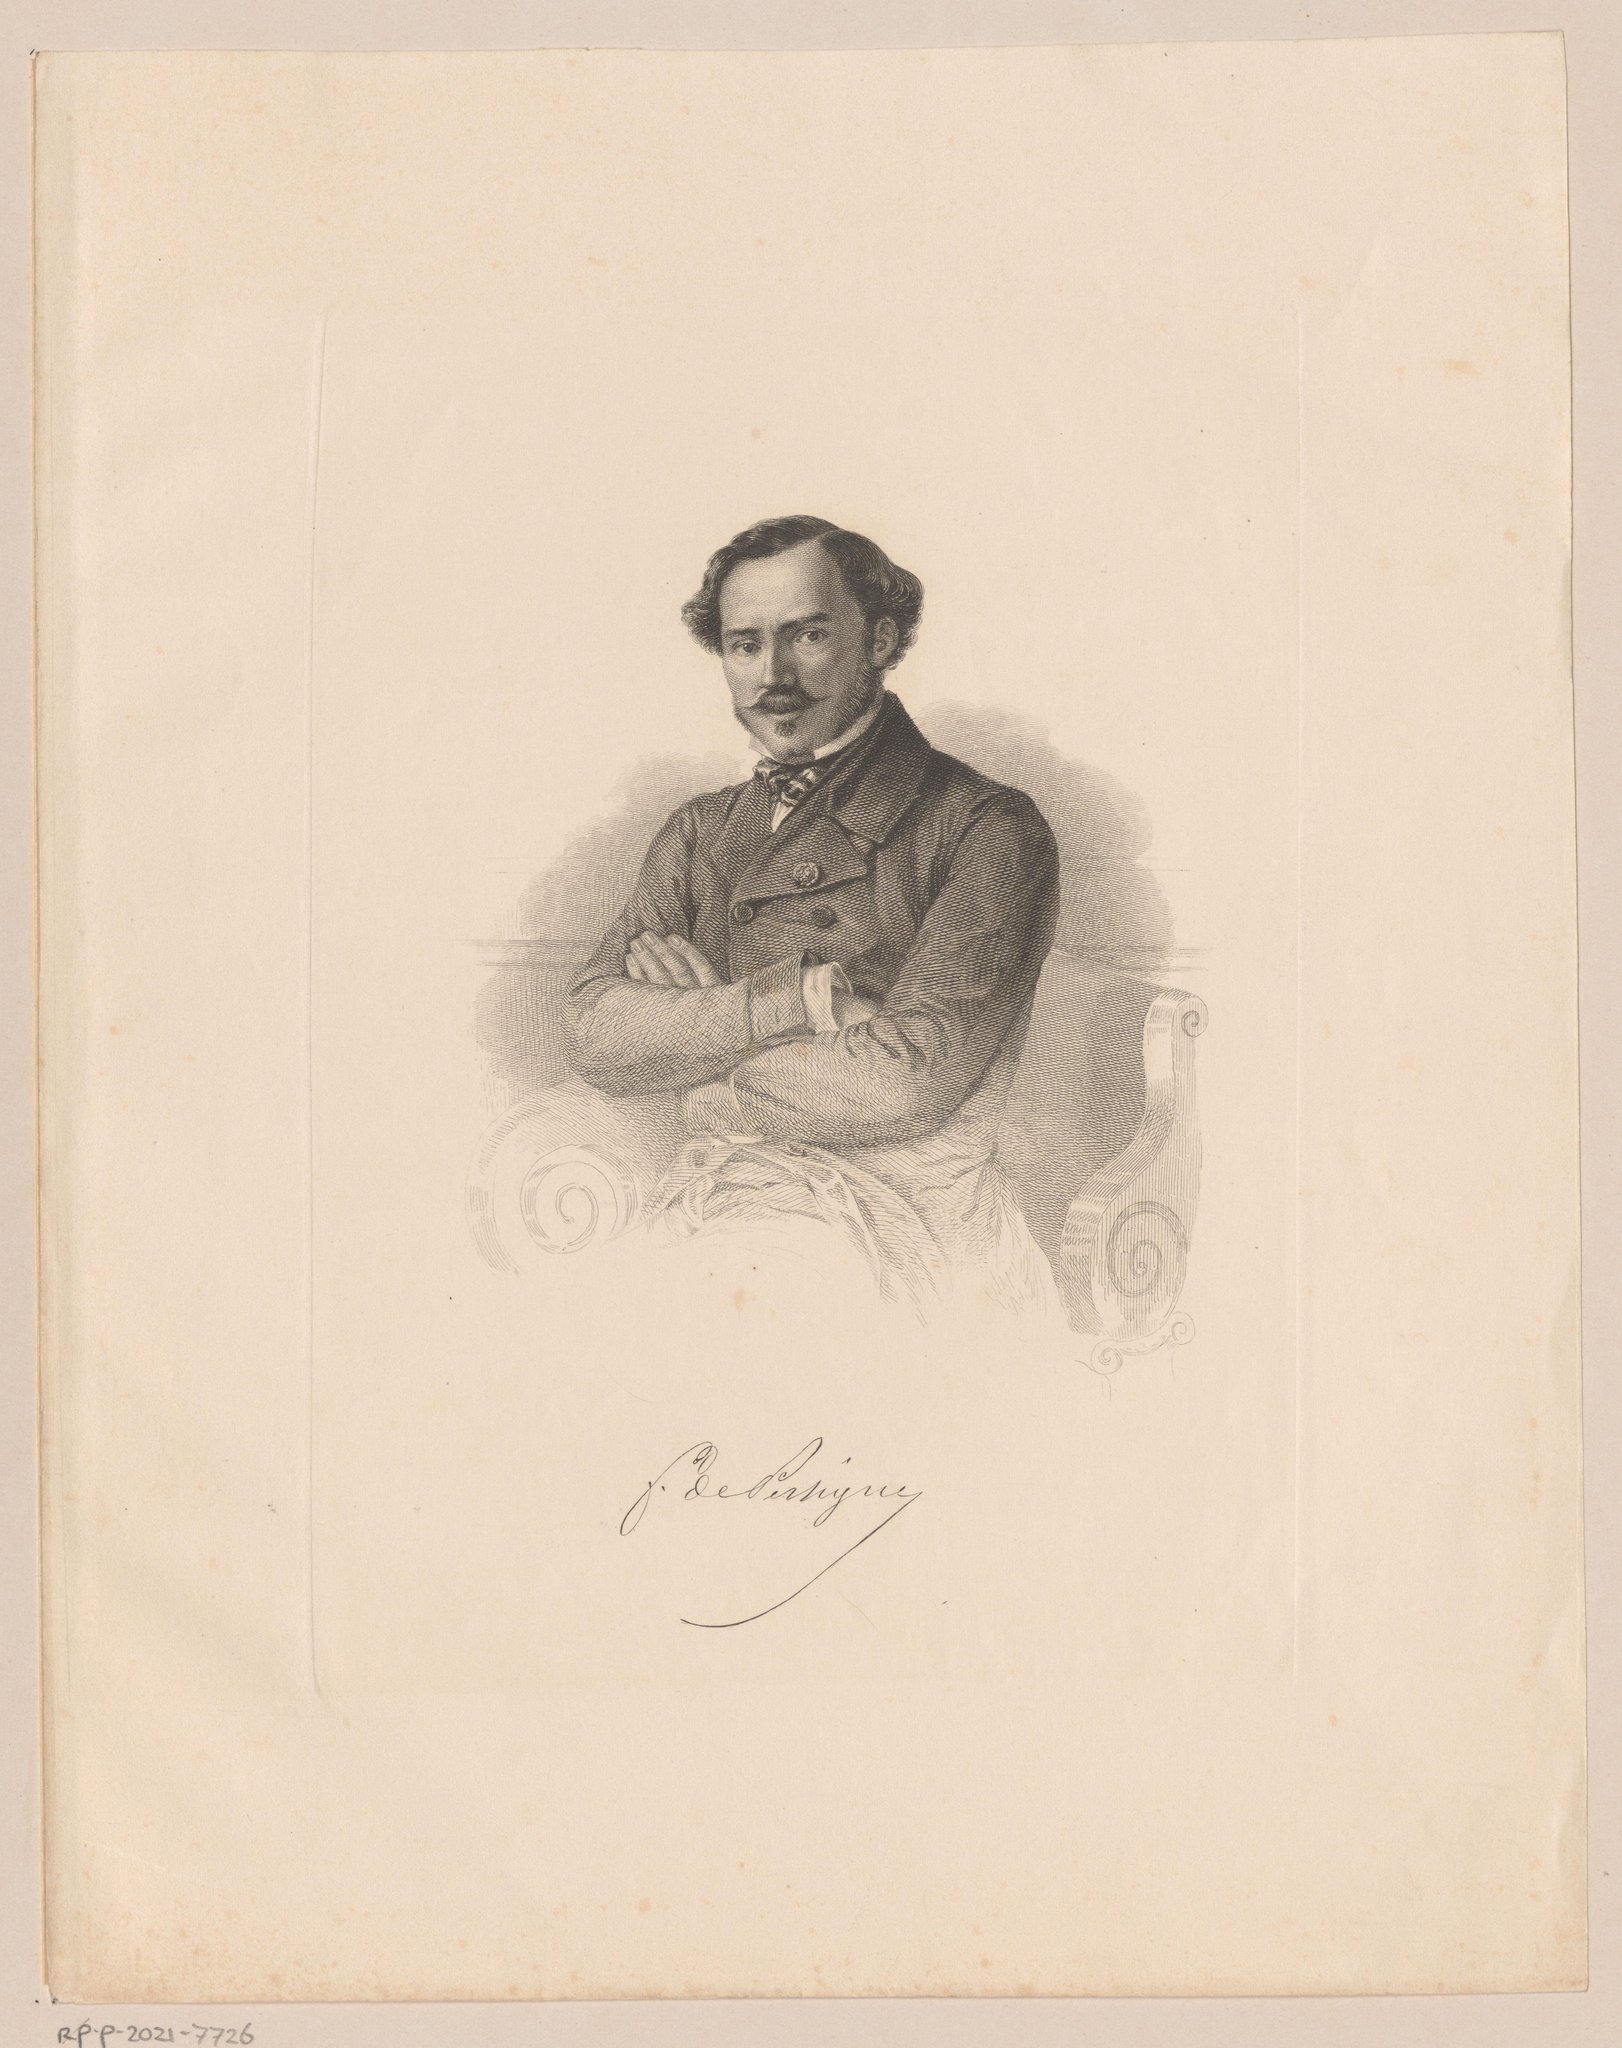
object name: print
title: Portret van Jean-Gilbert Victor Fialin, duc de Persigny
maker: Anonymous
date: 1830-1899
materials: paper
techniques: engraving, etching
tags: politician, moustache, adult man, historical persons